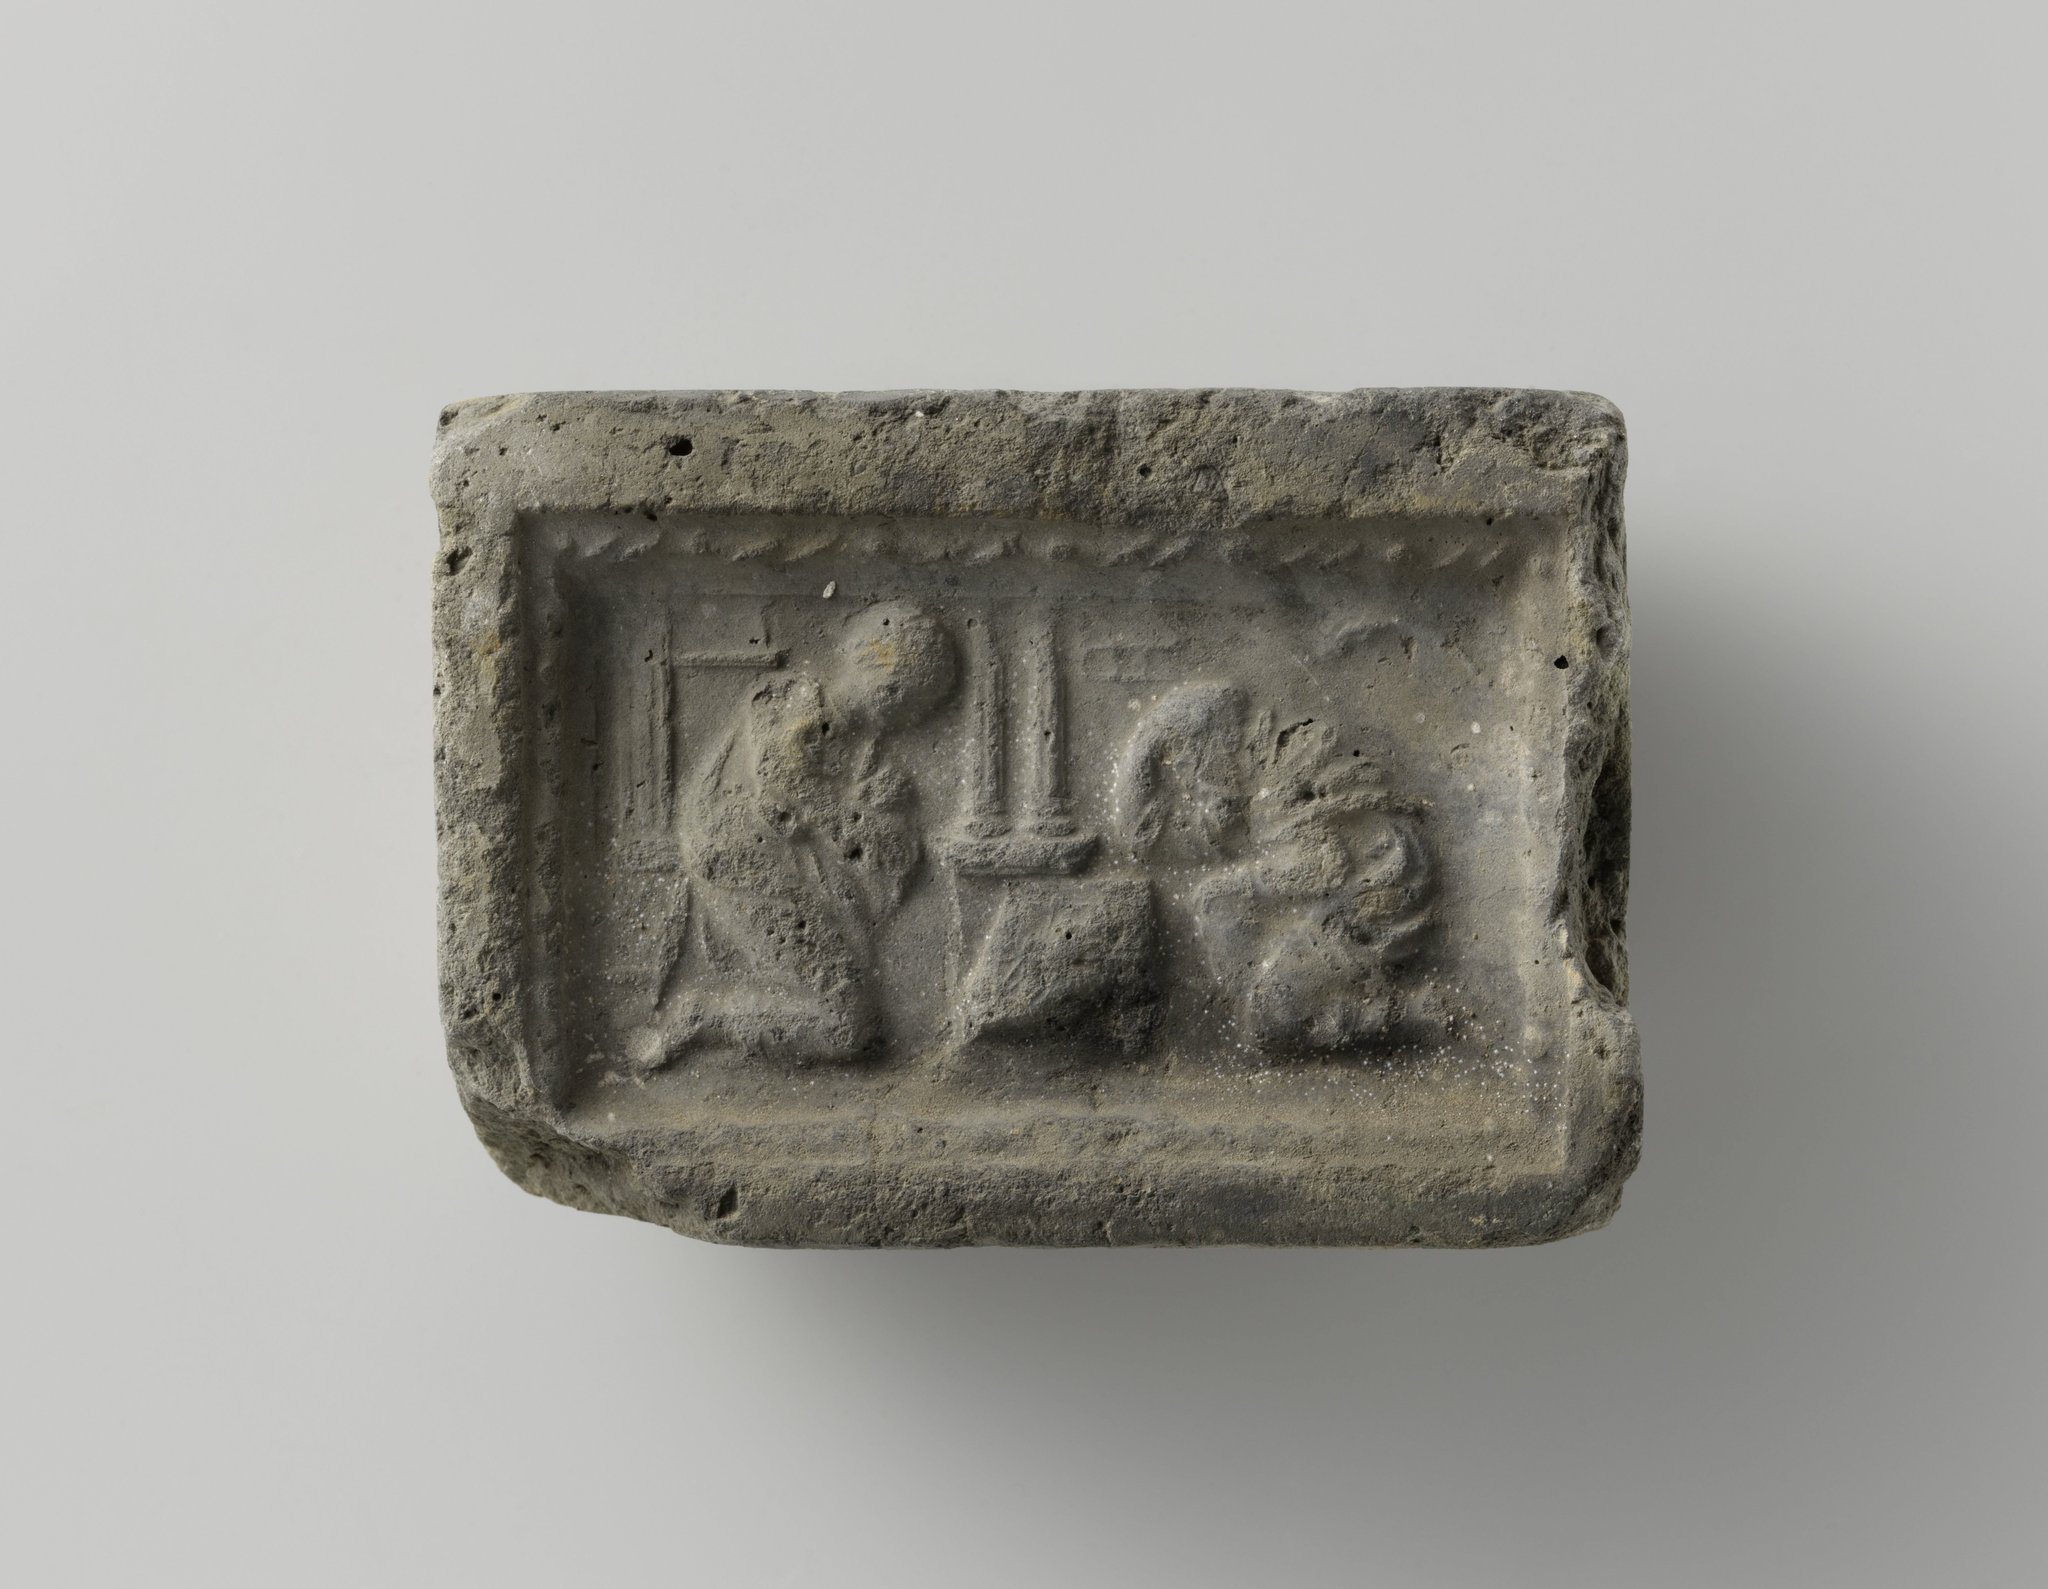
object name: architectural element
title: Haardsteen, waarop Simeon in de tempel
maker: Anonymous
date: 1400-1950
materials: earthenware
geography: southern netherlands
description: Haardsteen, waarop Simeon in de tempel met rijk georneerde rand. Van fijne gebakken aarde.